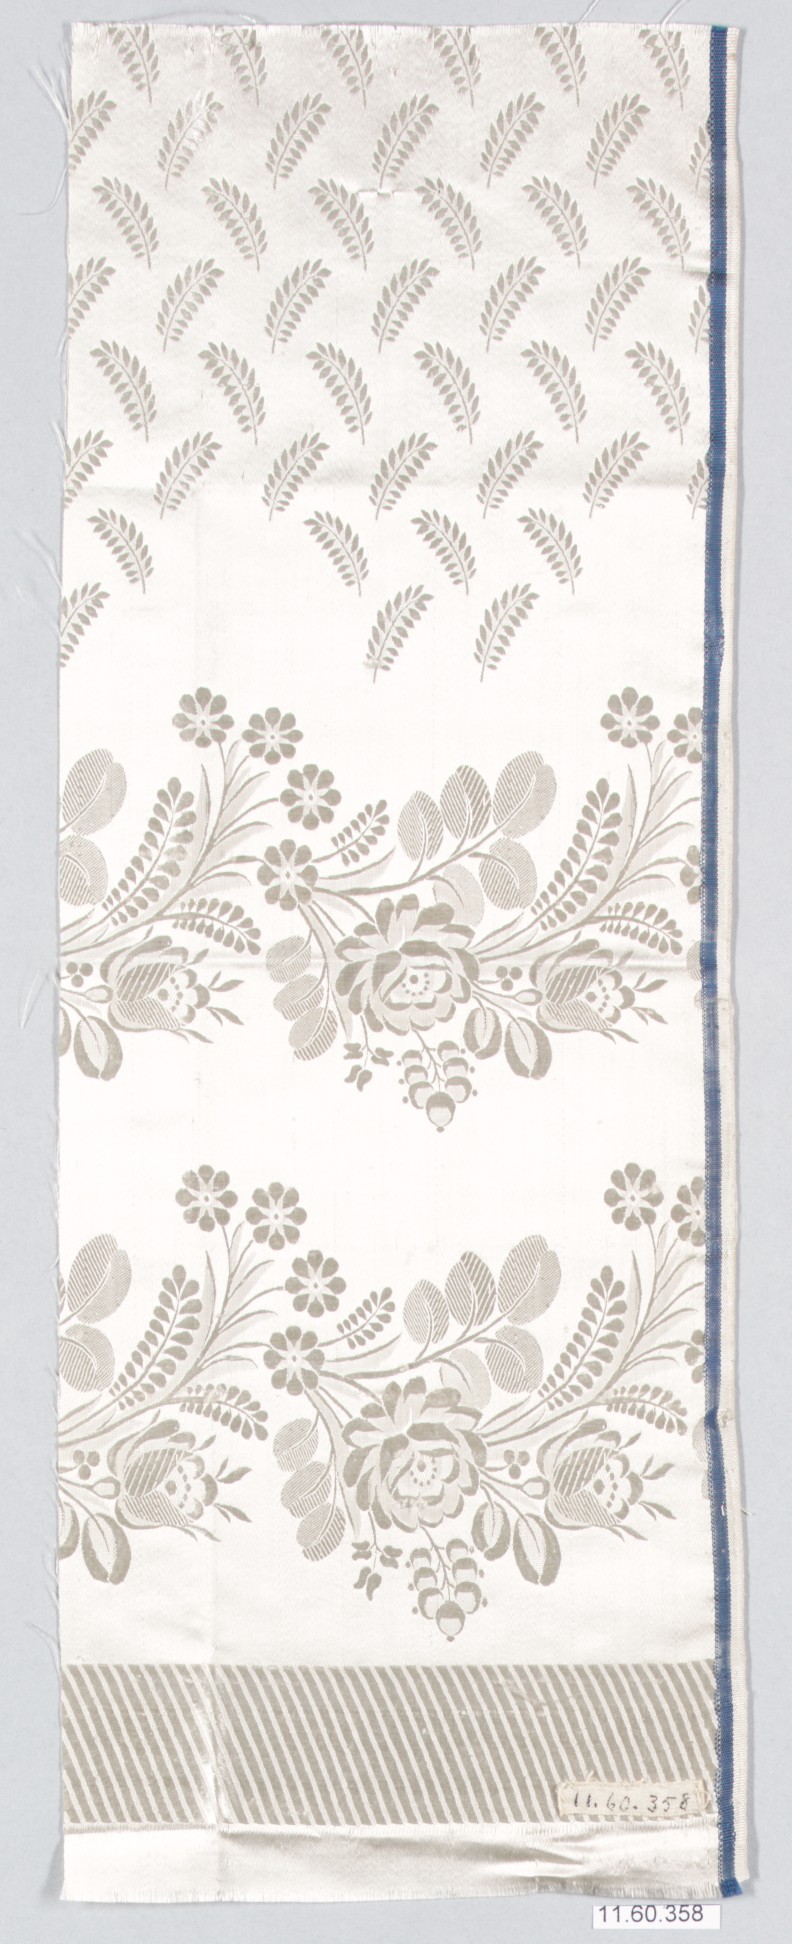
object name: fragment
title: Fragments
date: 1801-1900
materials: silk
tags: flowers,leaves